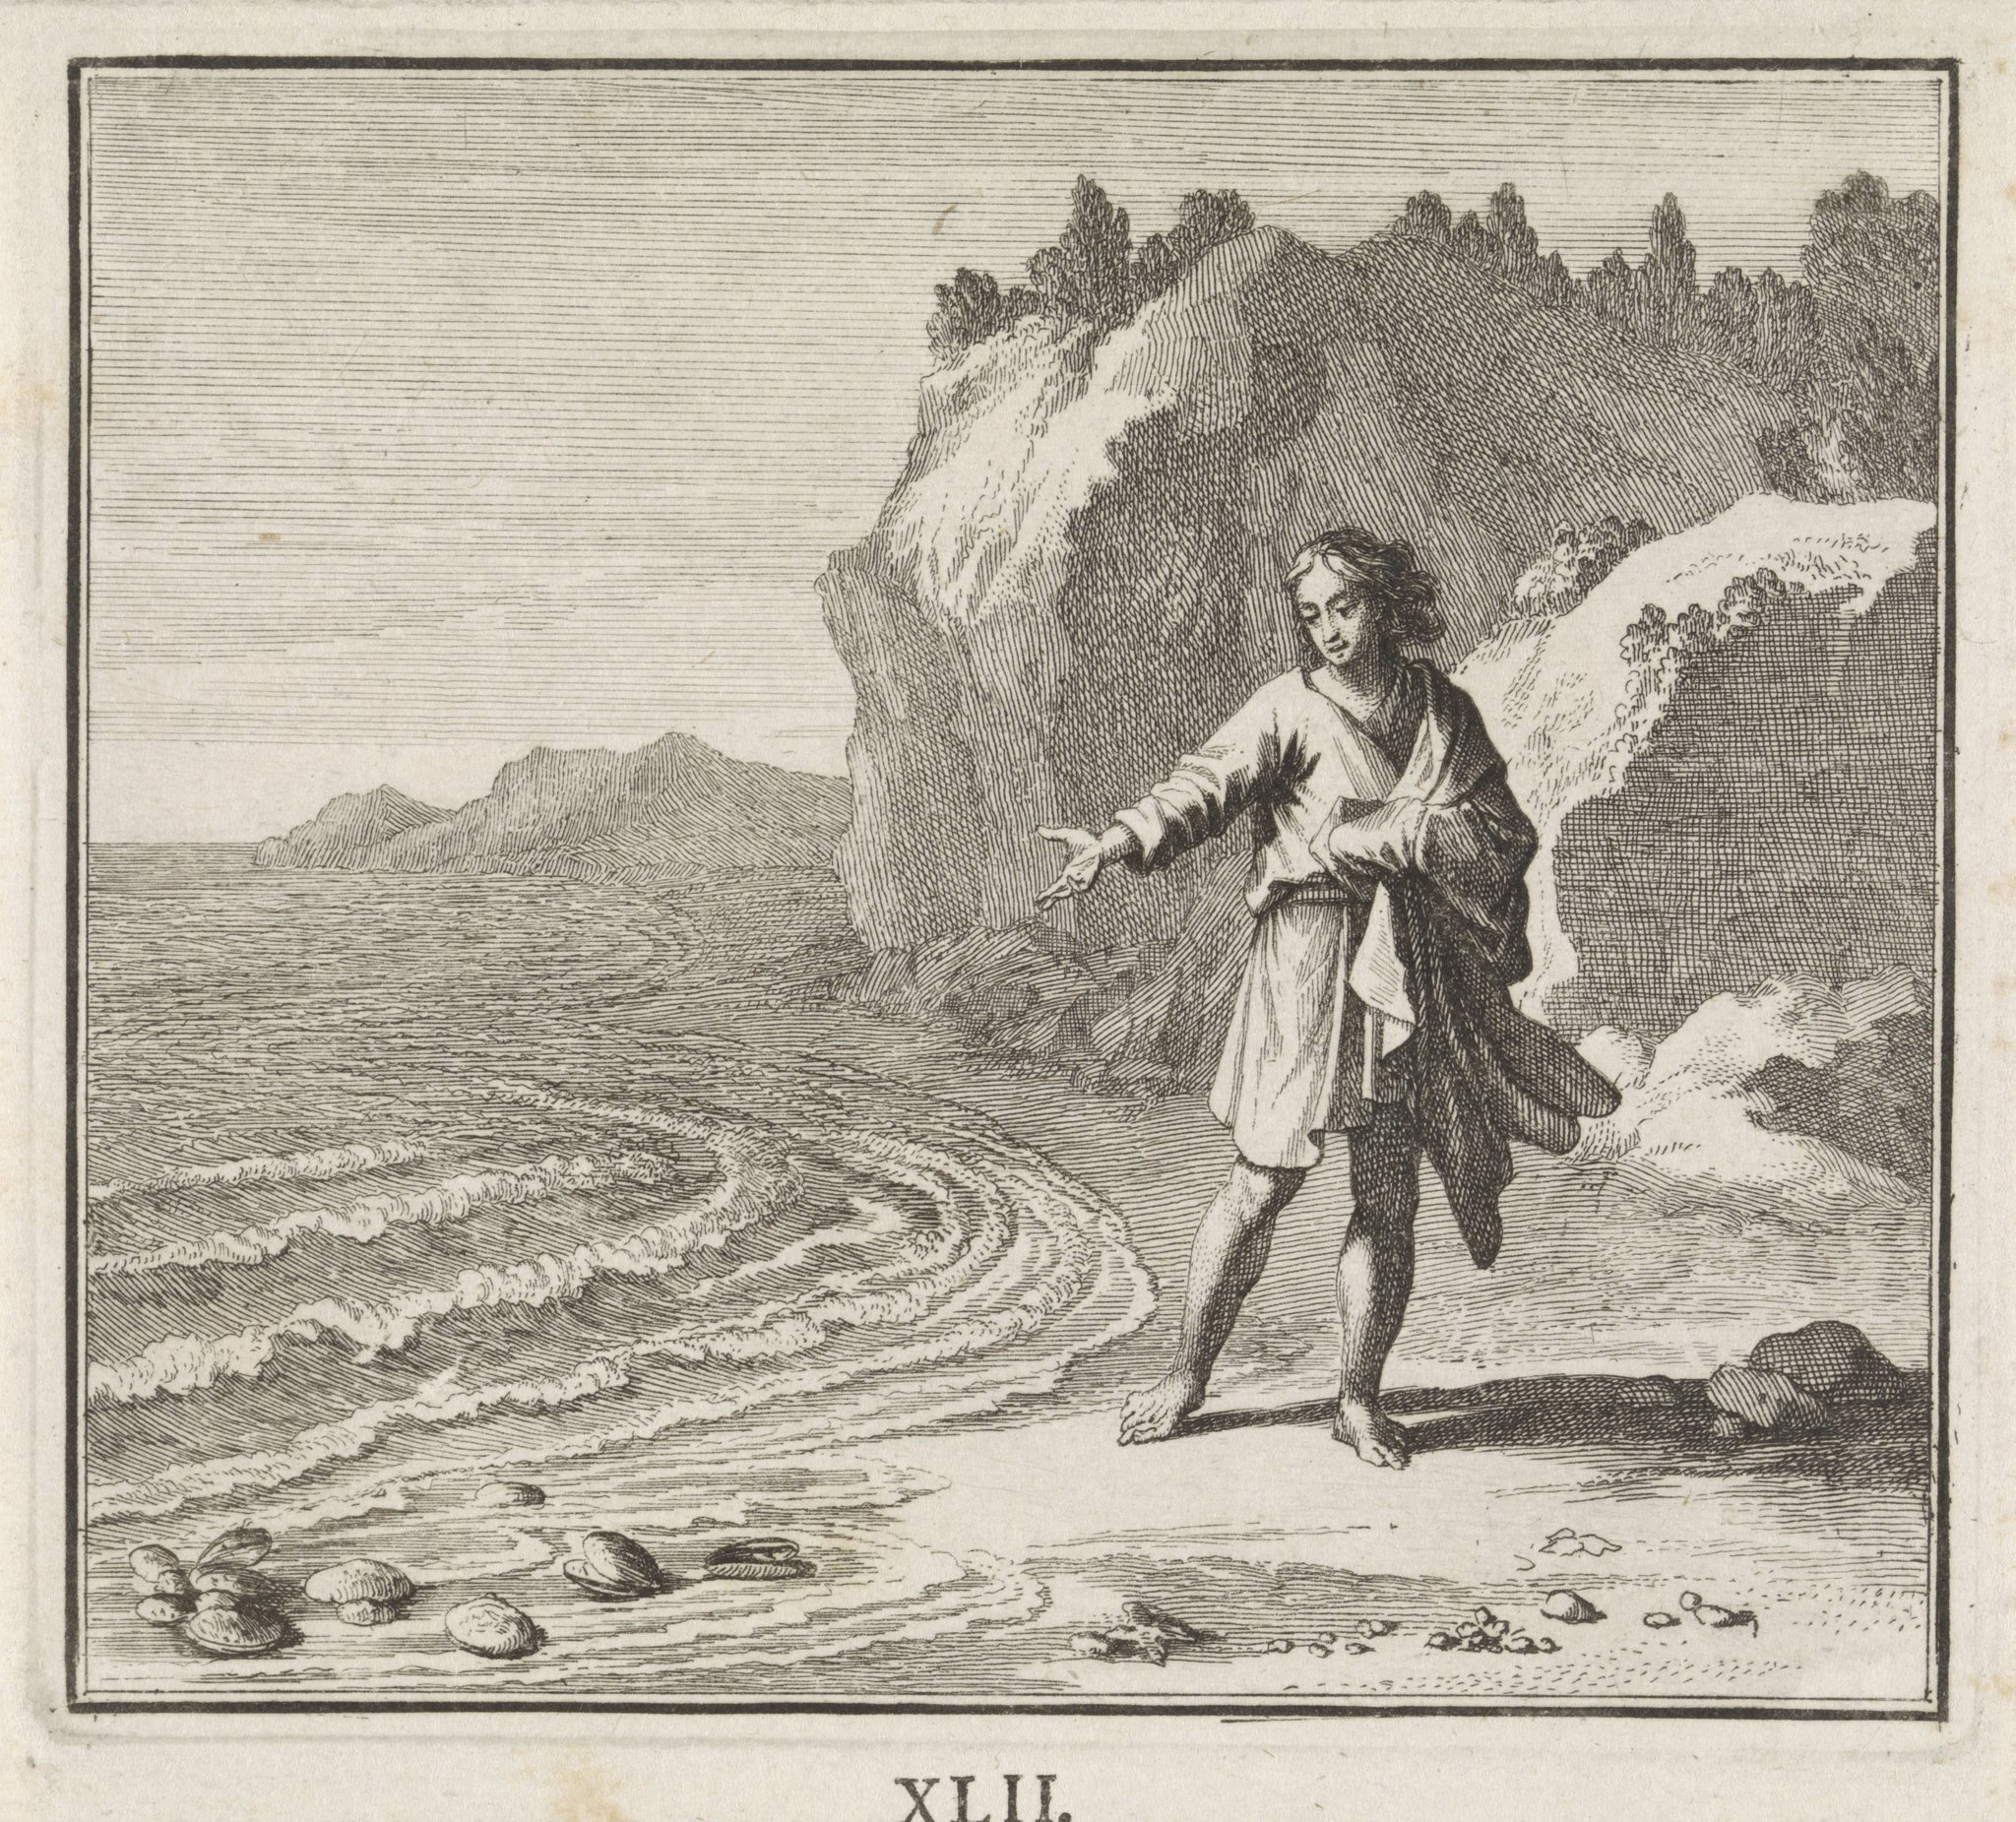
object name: print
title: Embleem: schelpen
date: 1695-1705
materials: paper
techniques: etching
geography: nuremberg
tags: rocky coast, molluscs, beach, abstract ideas and concepts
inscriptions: collector's mark: Lugt 2228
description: Boekillustratie voor Weigel, Christoph. Ethica Naturalis seu Documenta Moralia e Variis rerum Naturalium proprietatibus Virtutum Vitiorumq symbolicis imaginibus collecta. Neurenberg: Christoph Weigel: c. 1700.